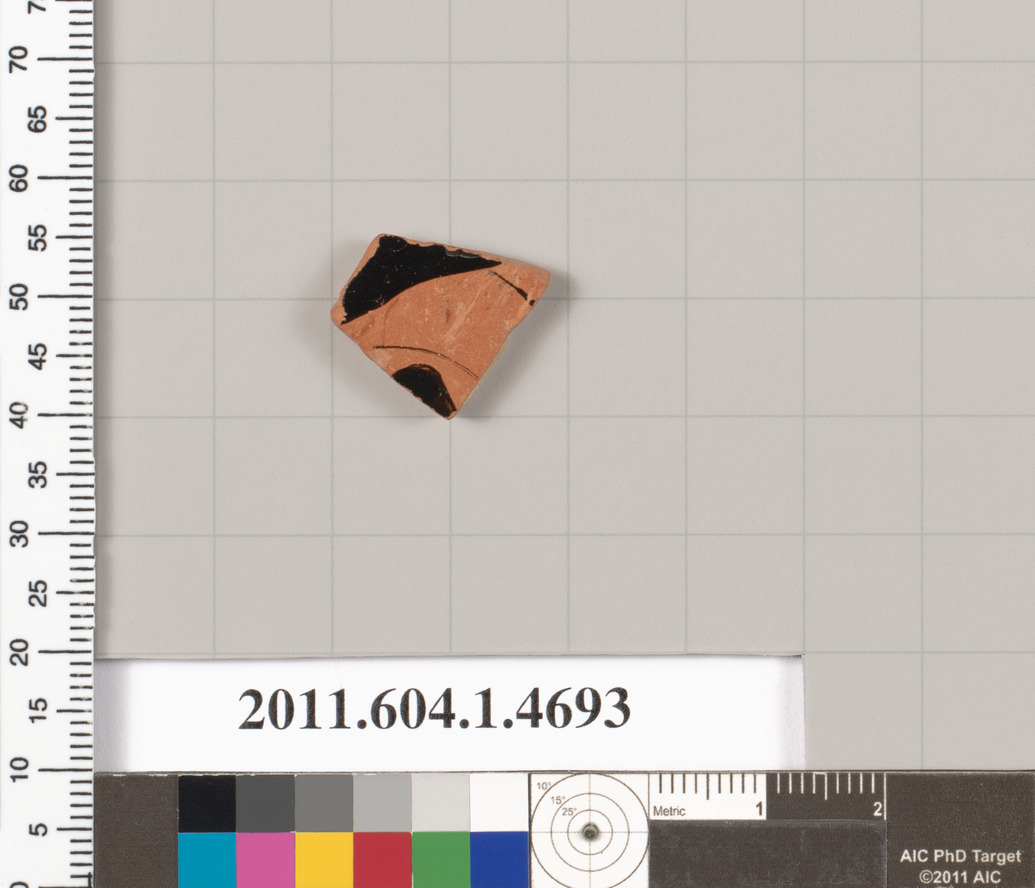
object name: kylix fragment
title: Terracotta fragment of a kylix (drinking cup)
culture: greek, attic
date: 475-451 BCE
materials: terracotta